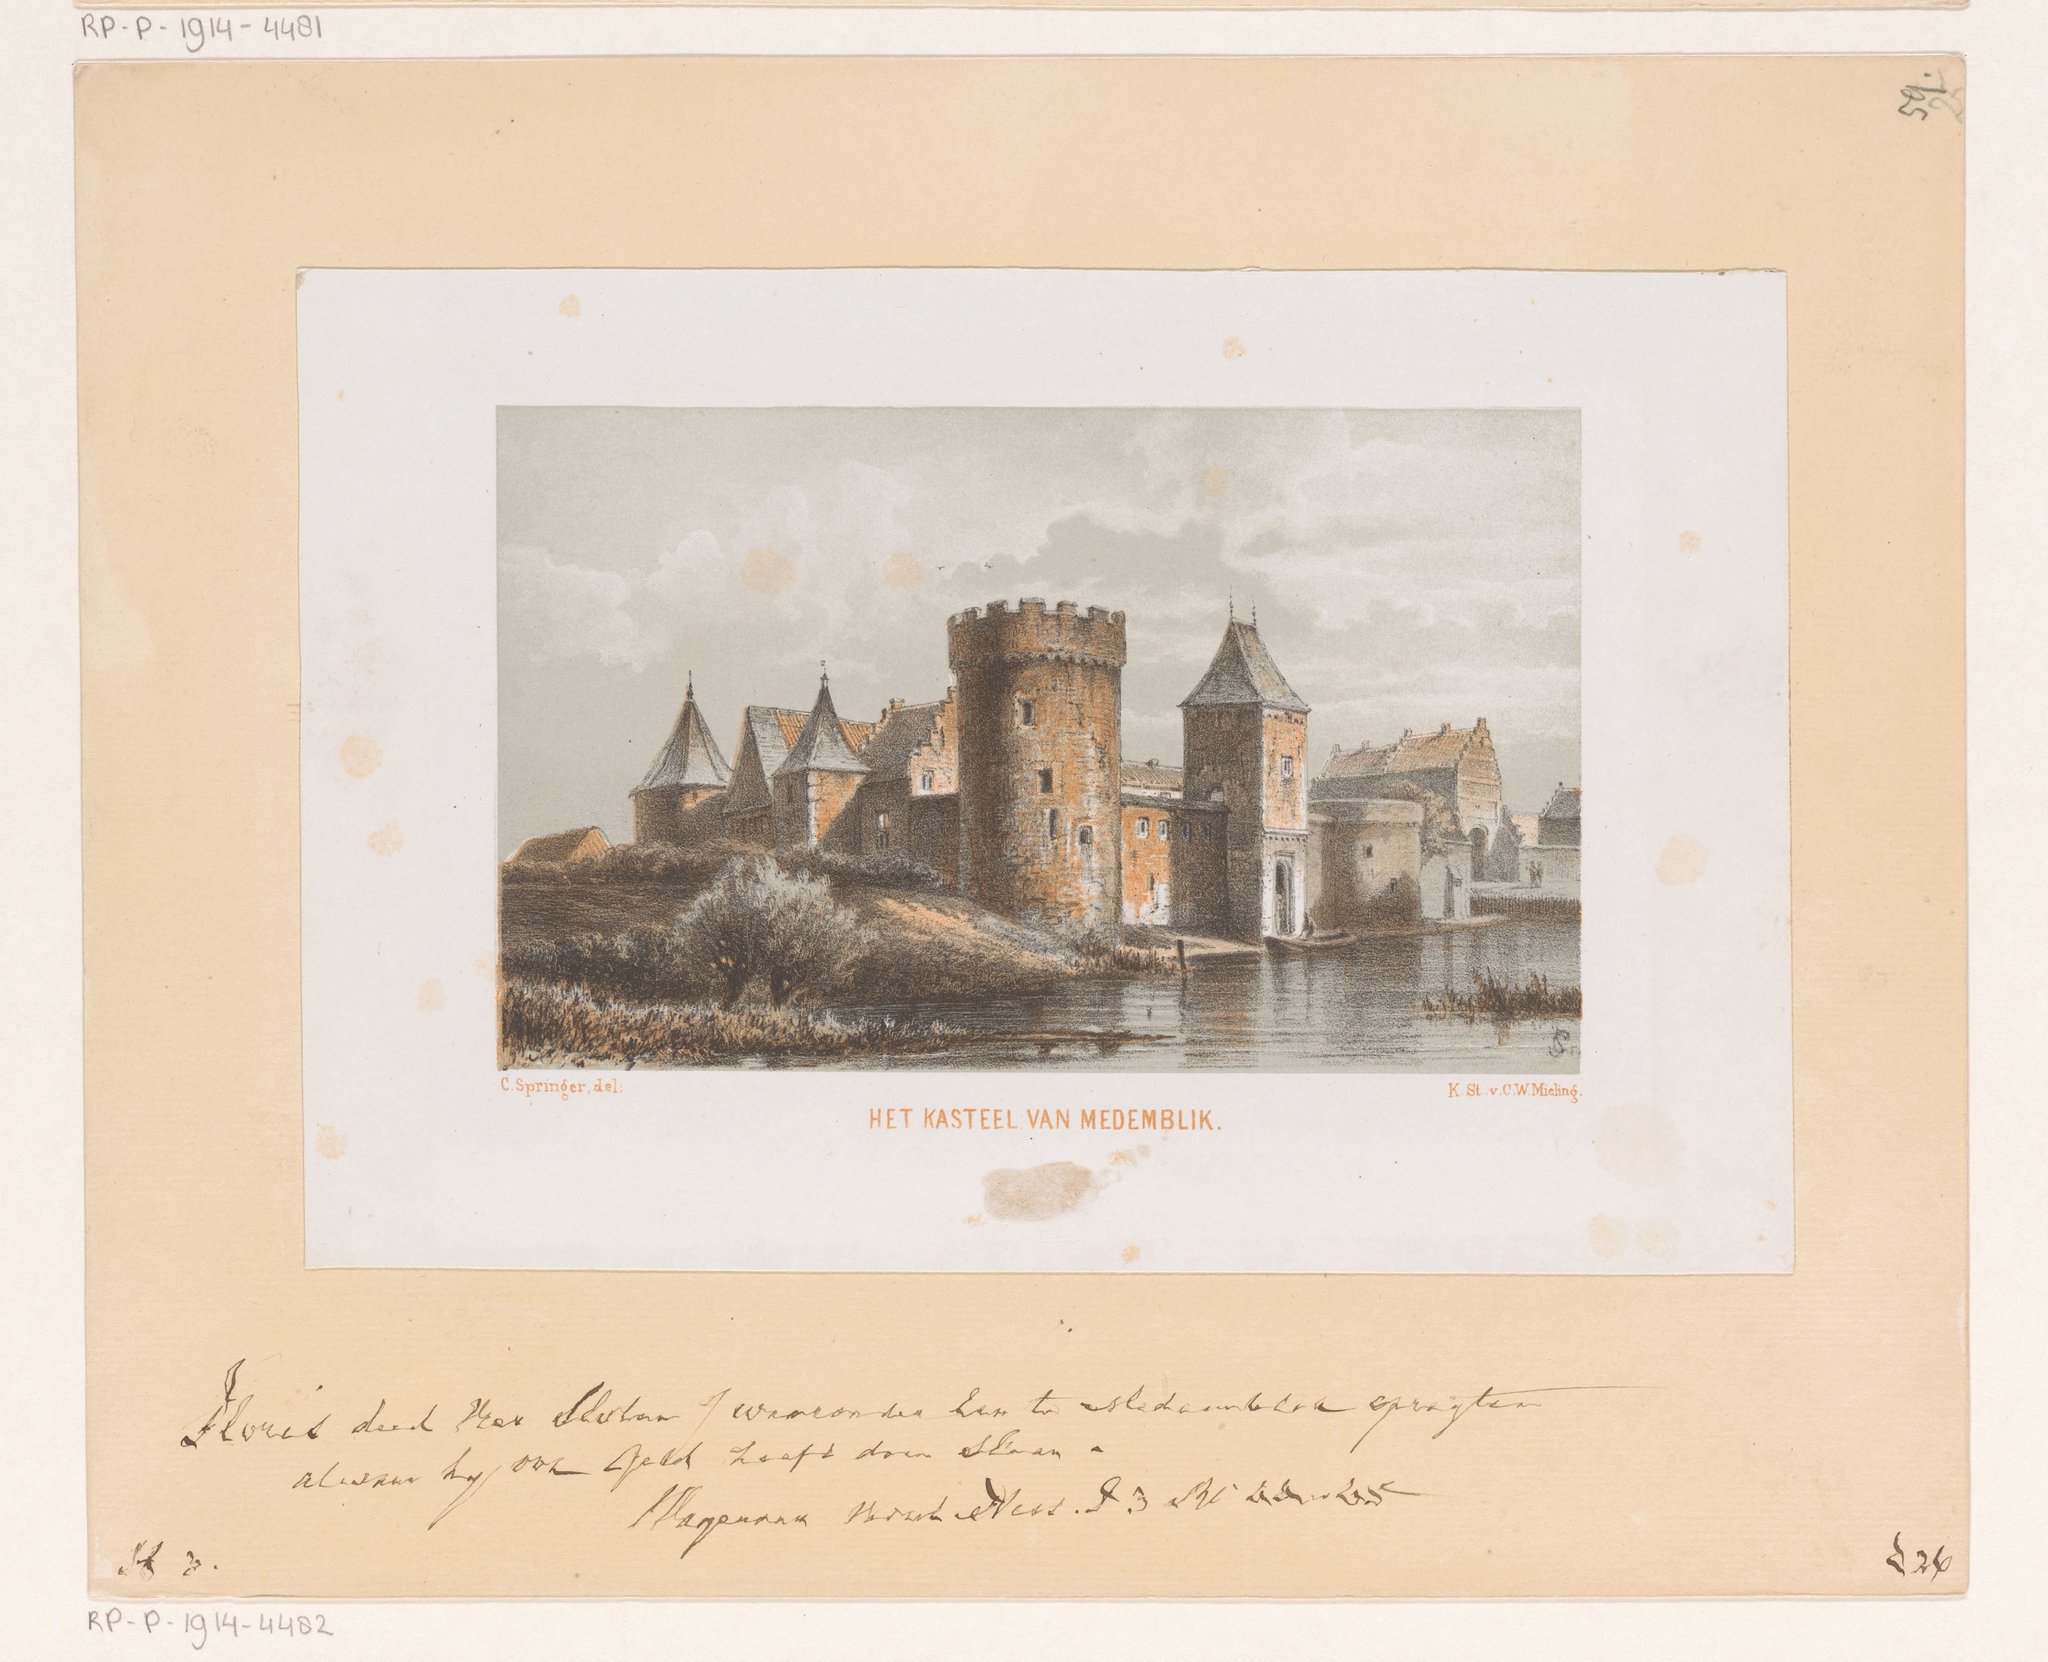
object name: print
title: Het kasteel van Medemblik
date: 1847-1865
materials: paper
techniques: tone lithography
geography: the hague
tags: castle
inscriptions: collector's mark: Lugt 2228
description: Een roeiboot legt aan bij het kasteel van Medemblik.